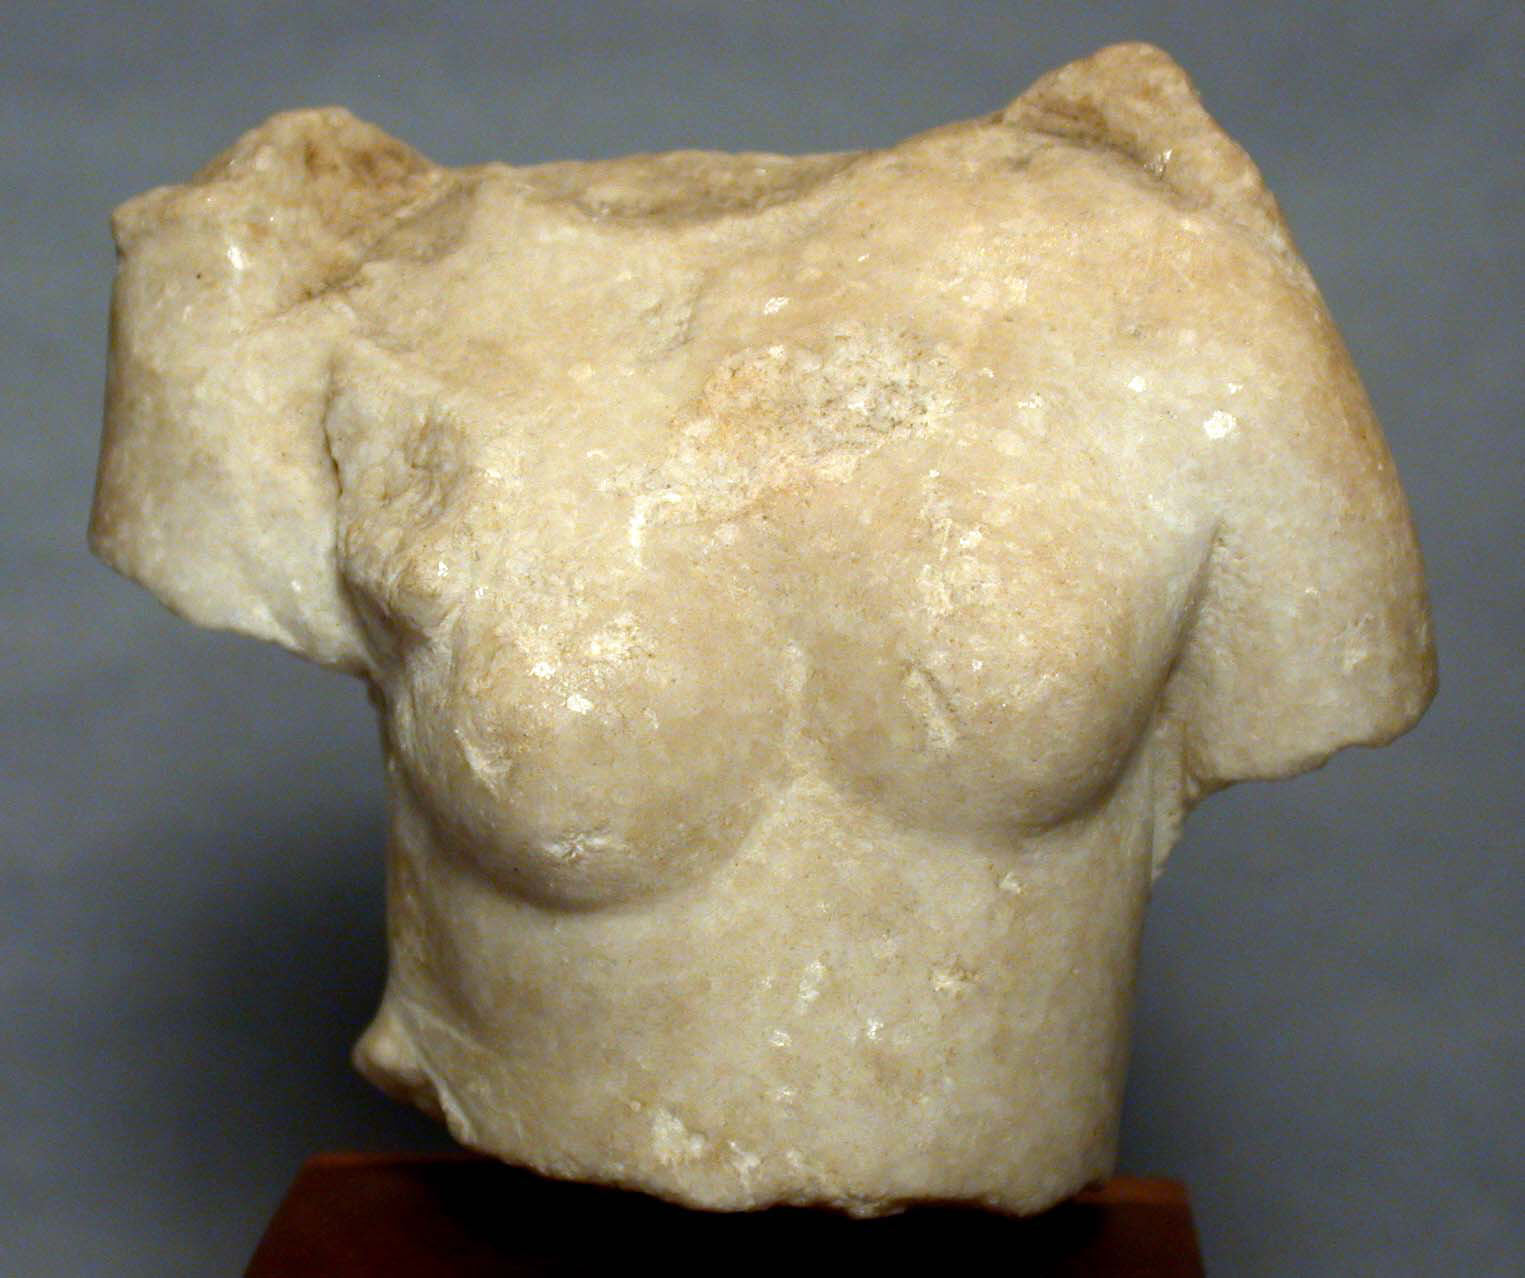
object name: torso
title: Marble torso of Aphrodite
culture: greek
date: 200-101 BCE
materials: marble